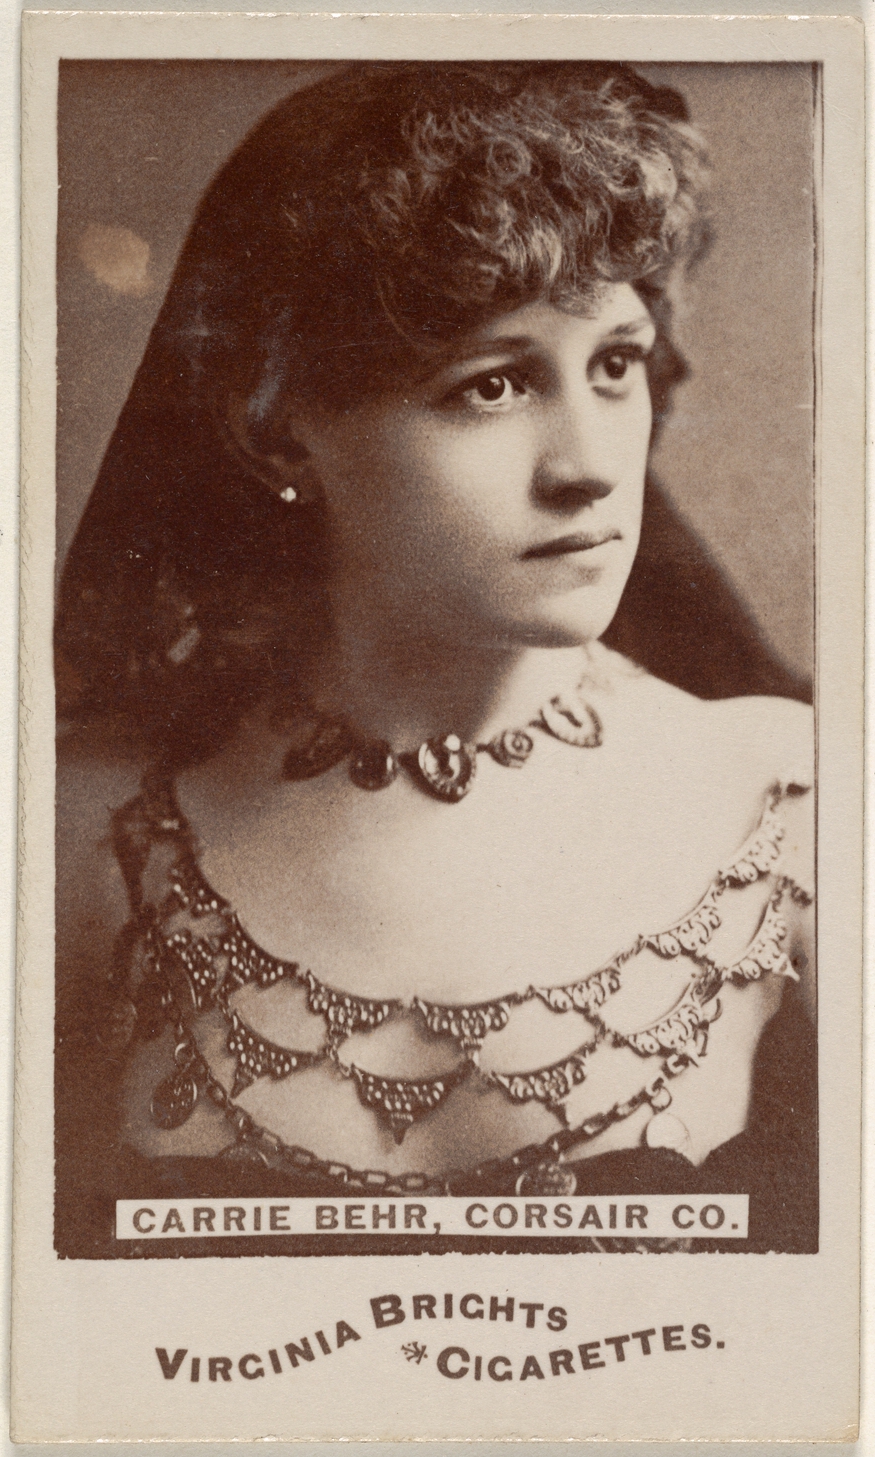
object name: photograph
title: Carrie Behr, Corsair Co., from the Actors and Actresses series (N45, Type 6) for Virginia Brights Cigarettes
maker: allen & ginter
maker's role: publisher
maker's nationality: american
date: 1888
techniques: albumen silver print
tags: portraits,women,actresses